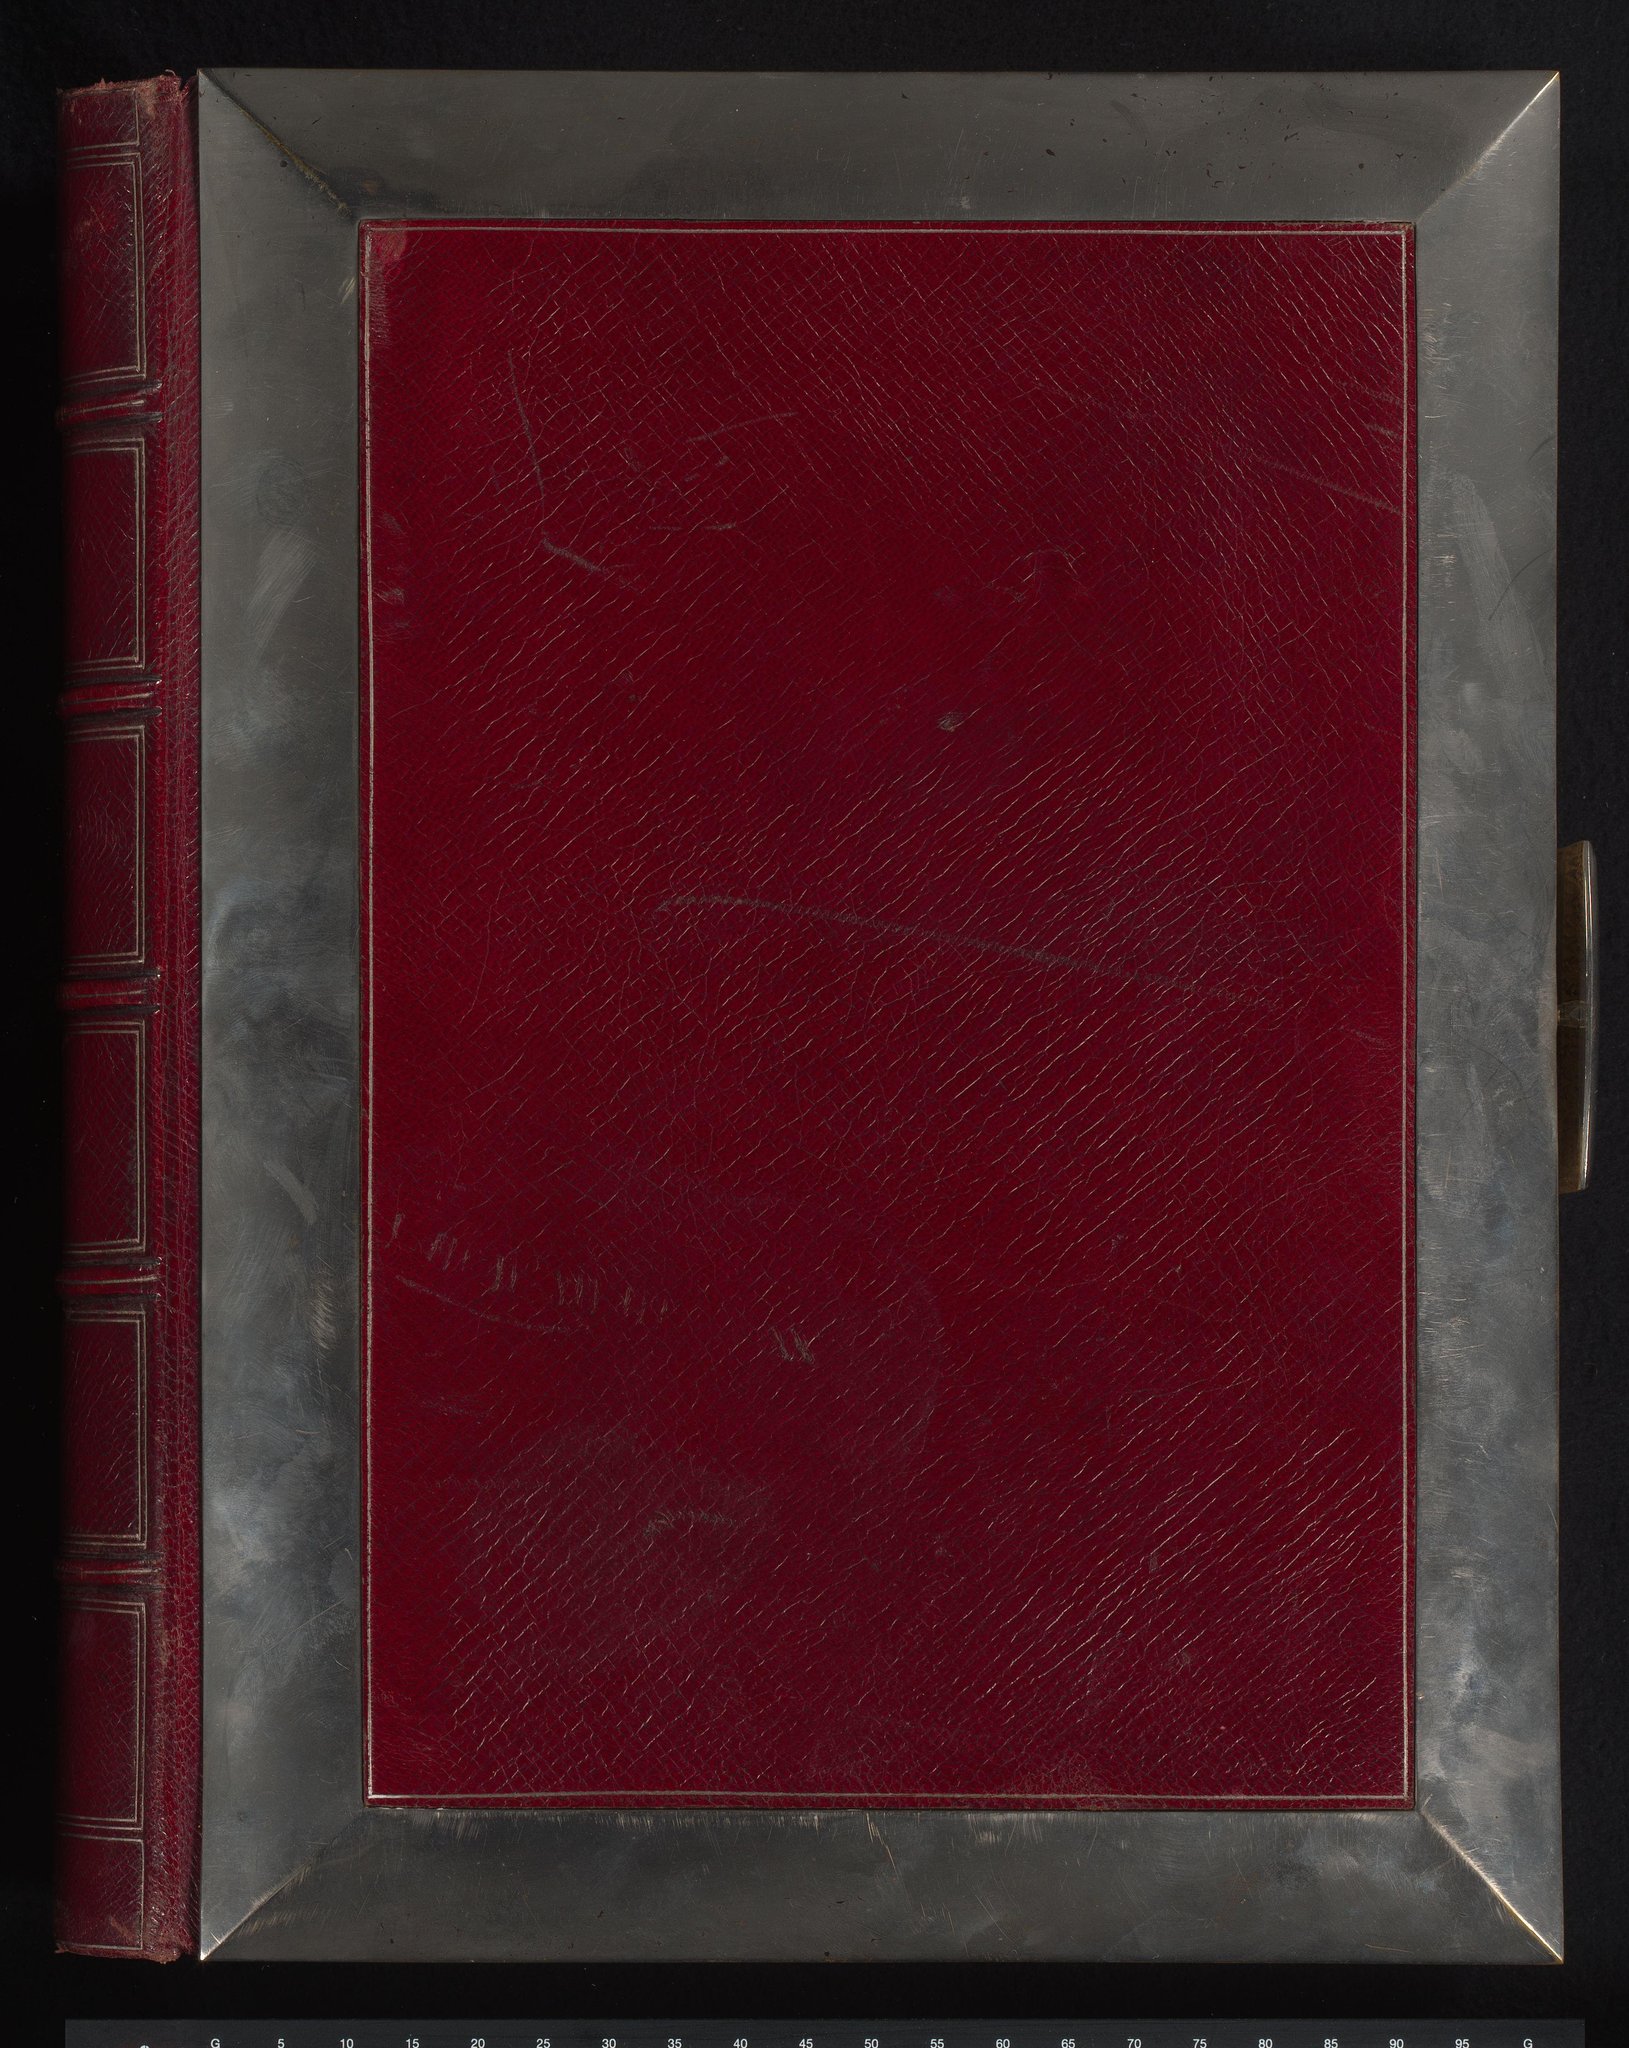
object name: slip in album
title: Fotoalbum met 81 foto's van Zweedse artiesten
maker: l.j. hartkamp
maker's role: advocaat, fotograaf, kunstverzamelaar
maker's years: 1916-1999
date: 1860-1900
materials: cardboard, leather, metal, paper, photographic support, textile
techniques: albumen print, marbling, printing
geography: sweden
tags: historical persons - bb - woman, historical persons, portrait of actor, actress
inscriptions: collector's mark: ‘DIENST/ VERSPREIDE/ RIJKSKOLLEKTIES/ (...) A 684’, retailer's mark: ‘Angne Mon GIRARD & Cie/ MAYOT LYON/ Place St. Pierre, 23./ BRONZES, OBJETS D'ART/ Corbeilles de Mariages/ OBJETS RELIGIEUX/ TABLETTERIE FINE’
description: Fotoalbum met 30 pagina's met in totaal 81 foto's. Het album bevat 76 cartes-de-visite en 5 kabinetfoto's in met gouden lijnen omkaderde passe-partouts. Afgebeeld zijn portretten van Zweedse acteurs, actrices, operazangers en operazangeressen, waaronder Betty Almlöf, Anna Maria Strandberg en Sophie Cysch. De foto's zijn gemaakt door diverse fotografen, waaronder Gösta Florman (37), Selma Jacobsson (4) en Augusta Zetterling (3). Van 12 foto's is de fotograaf anoniem.